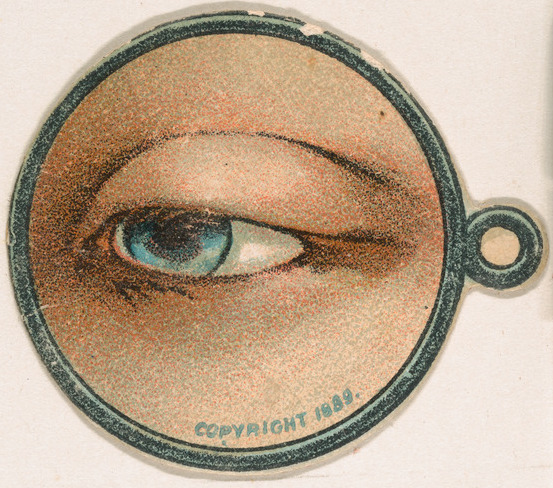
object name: print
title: Monocle and Eye (blue), from Jocular Ocular series (N221) issued by Kinney Bros.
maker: kinney brothers tobacco company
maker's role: publisher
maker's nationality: american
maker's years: 1869-2011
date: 1889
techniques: color lithograph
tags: eyes